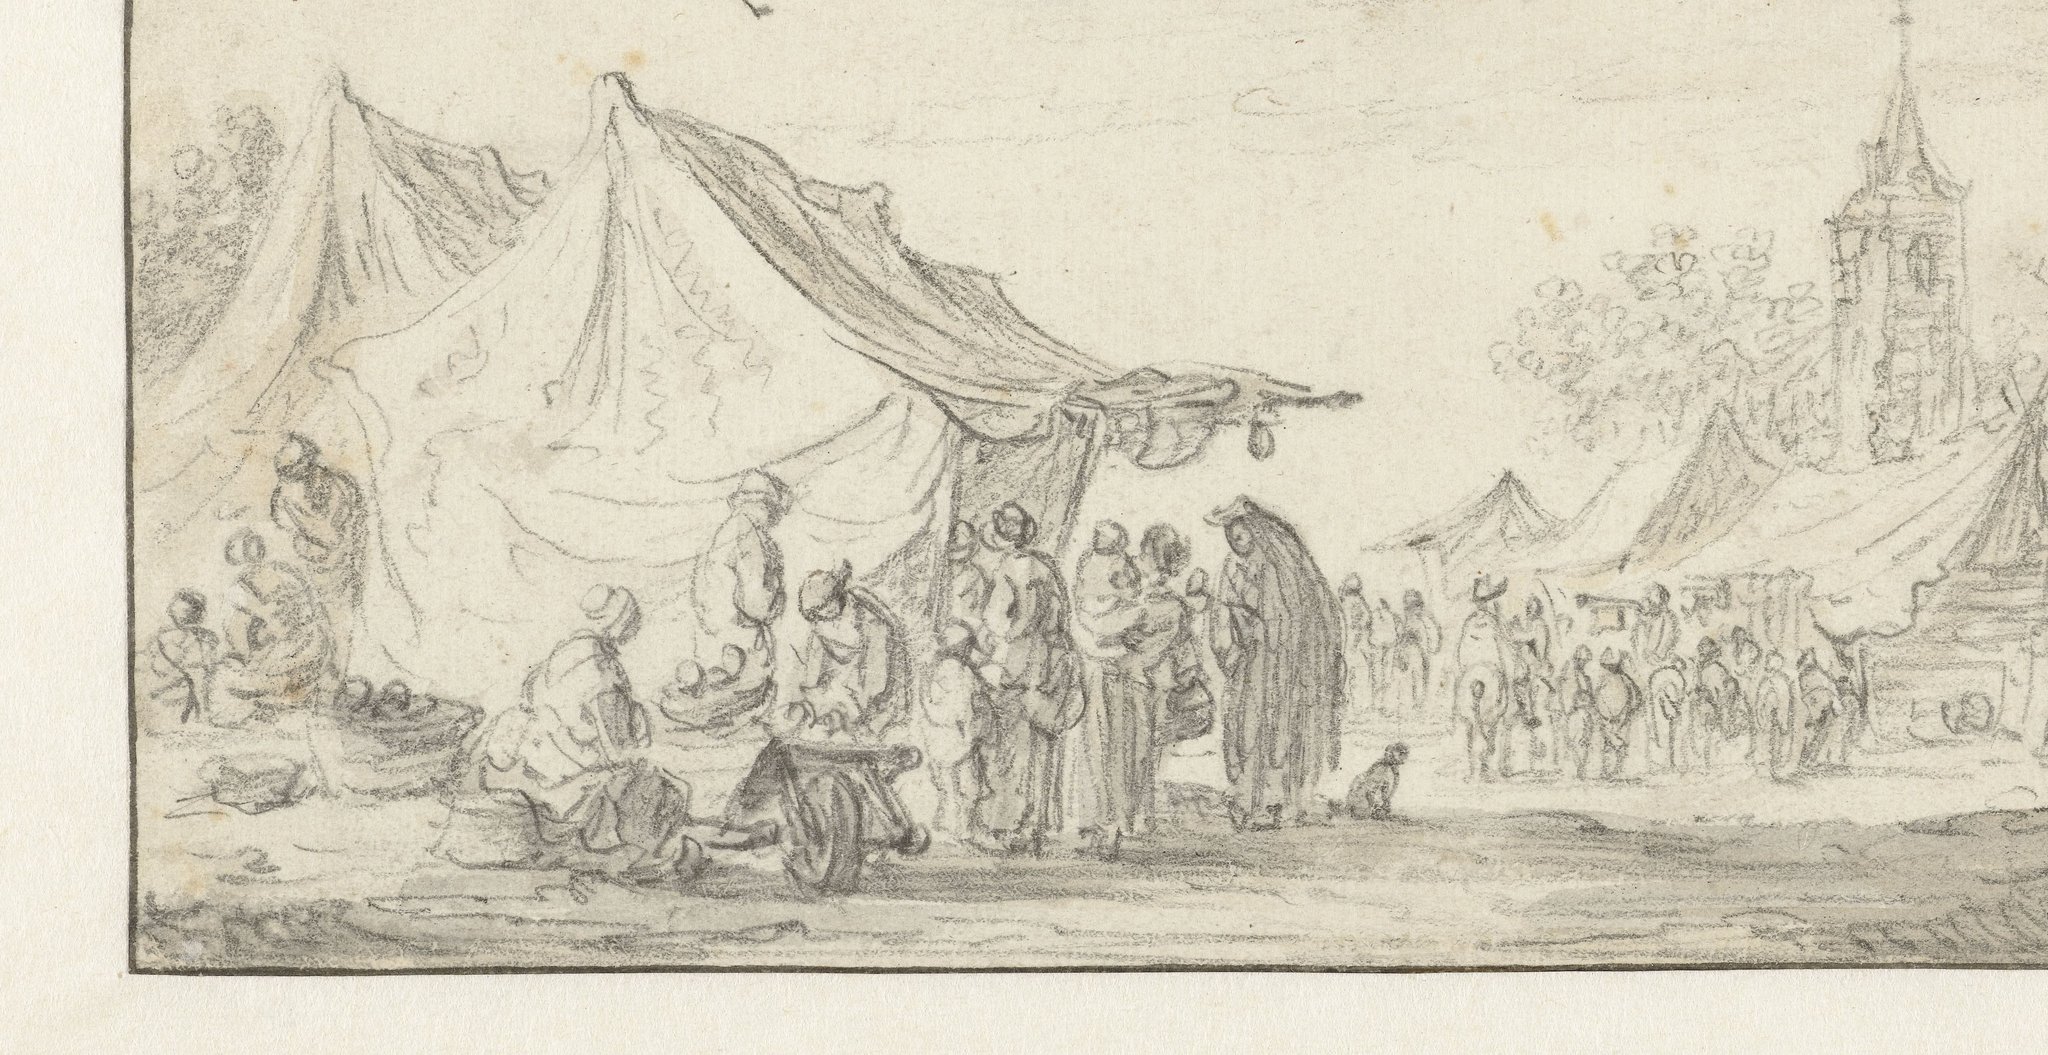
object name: drawing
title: Jaarmarkt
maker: jan van goyen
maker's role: draughtsman, painter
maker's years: 1596-1656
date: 1651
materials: chalk, paper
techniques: brush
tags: (annual) fair, trade fair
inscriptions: date: ‘1651’